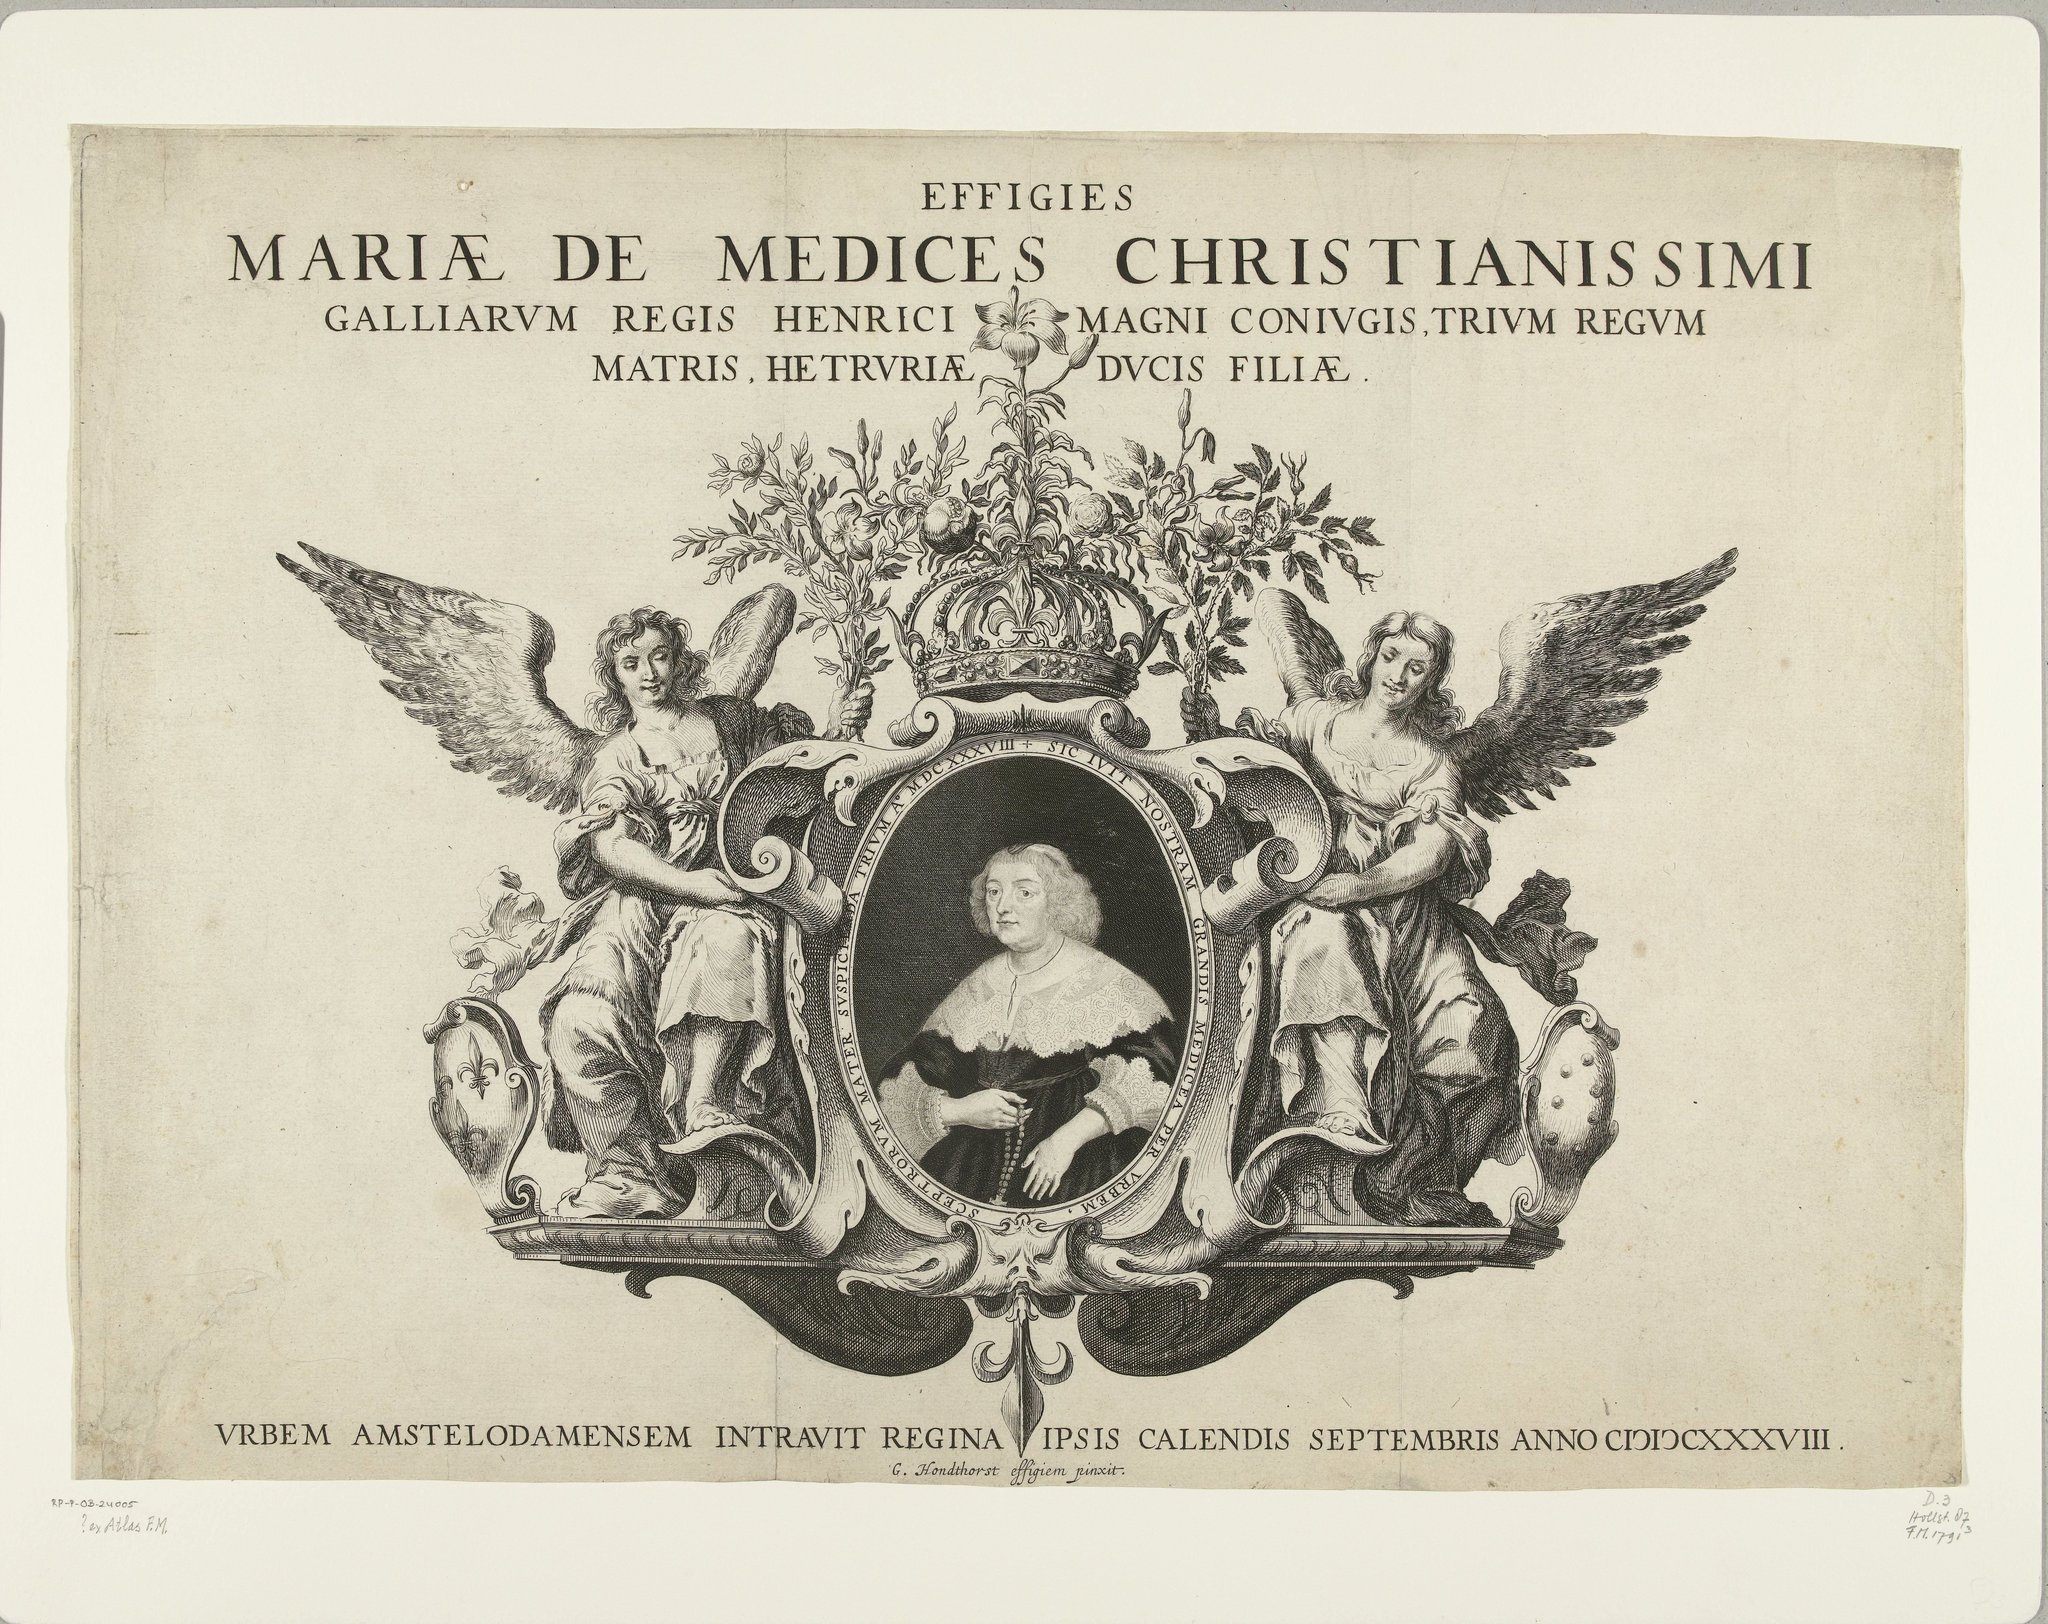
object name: print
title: Intocht van Maria de Medicis te Amsterdam (portret), 1638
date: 1638-1639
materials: paper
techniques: engraving, etching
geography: northern netherlands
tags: cologne, print maker, maria de' medici, triumphal entry and public reception, pageant, 'entrée solennelle', 'joyeuse entrée', amsterdam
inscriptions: collector's mark: Lugt 2228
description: Intocht van de Franse koningin Maria de Medicis te Amsterdam, 31 augustus 1638. Portret in een ongemonteerd ensemble bestaande uit een titelblad, een portret en zeven bladen van de stoet. Het portret van Maria de Medicis, ten halven lijve, links gewend met een rozenkrans in de rechterhand. In ovaal dat omgeven is door een met de Franse koningskroon gedekte cartouche. Aan beide zijden van de cartouche is een engel gezeten.